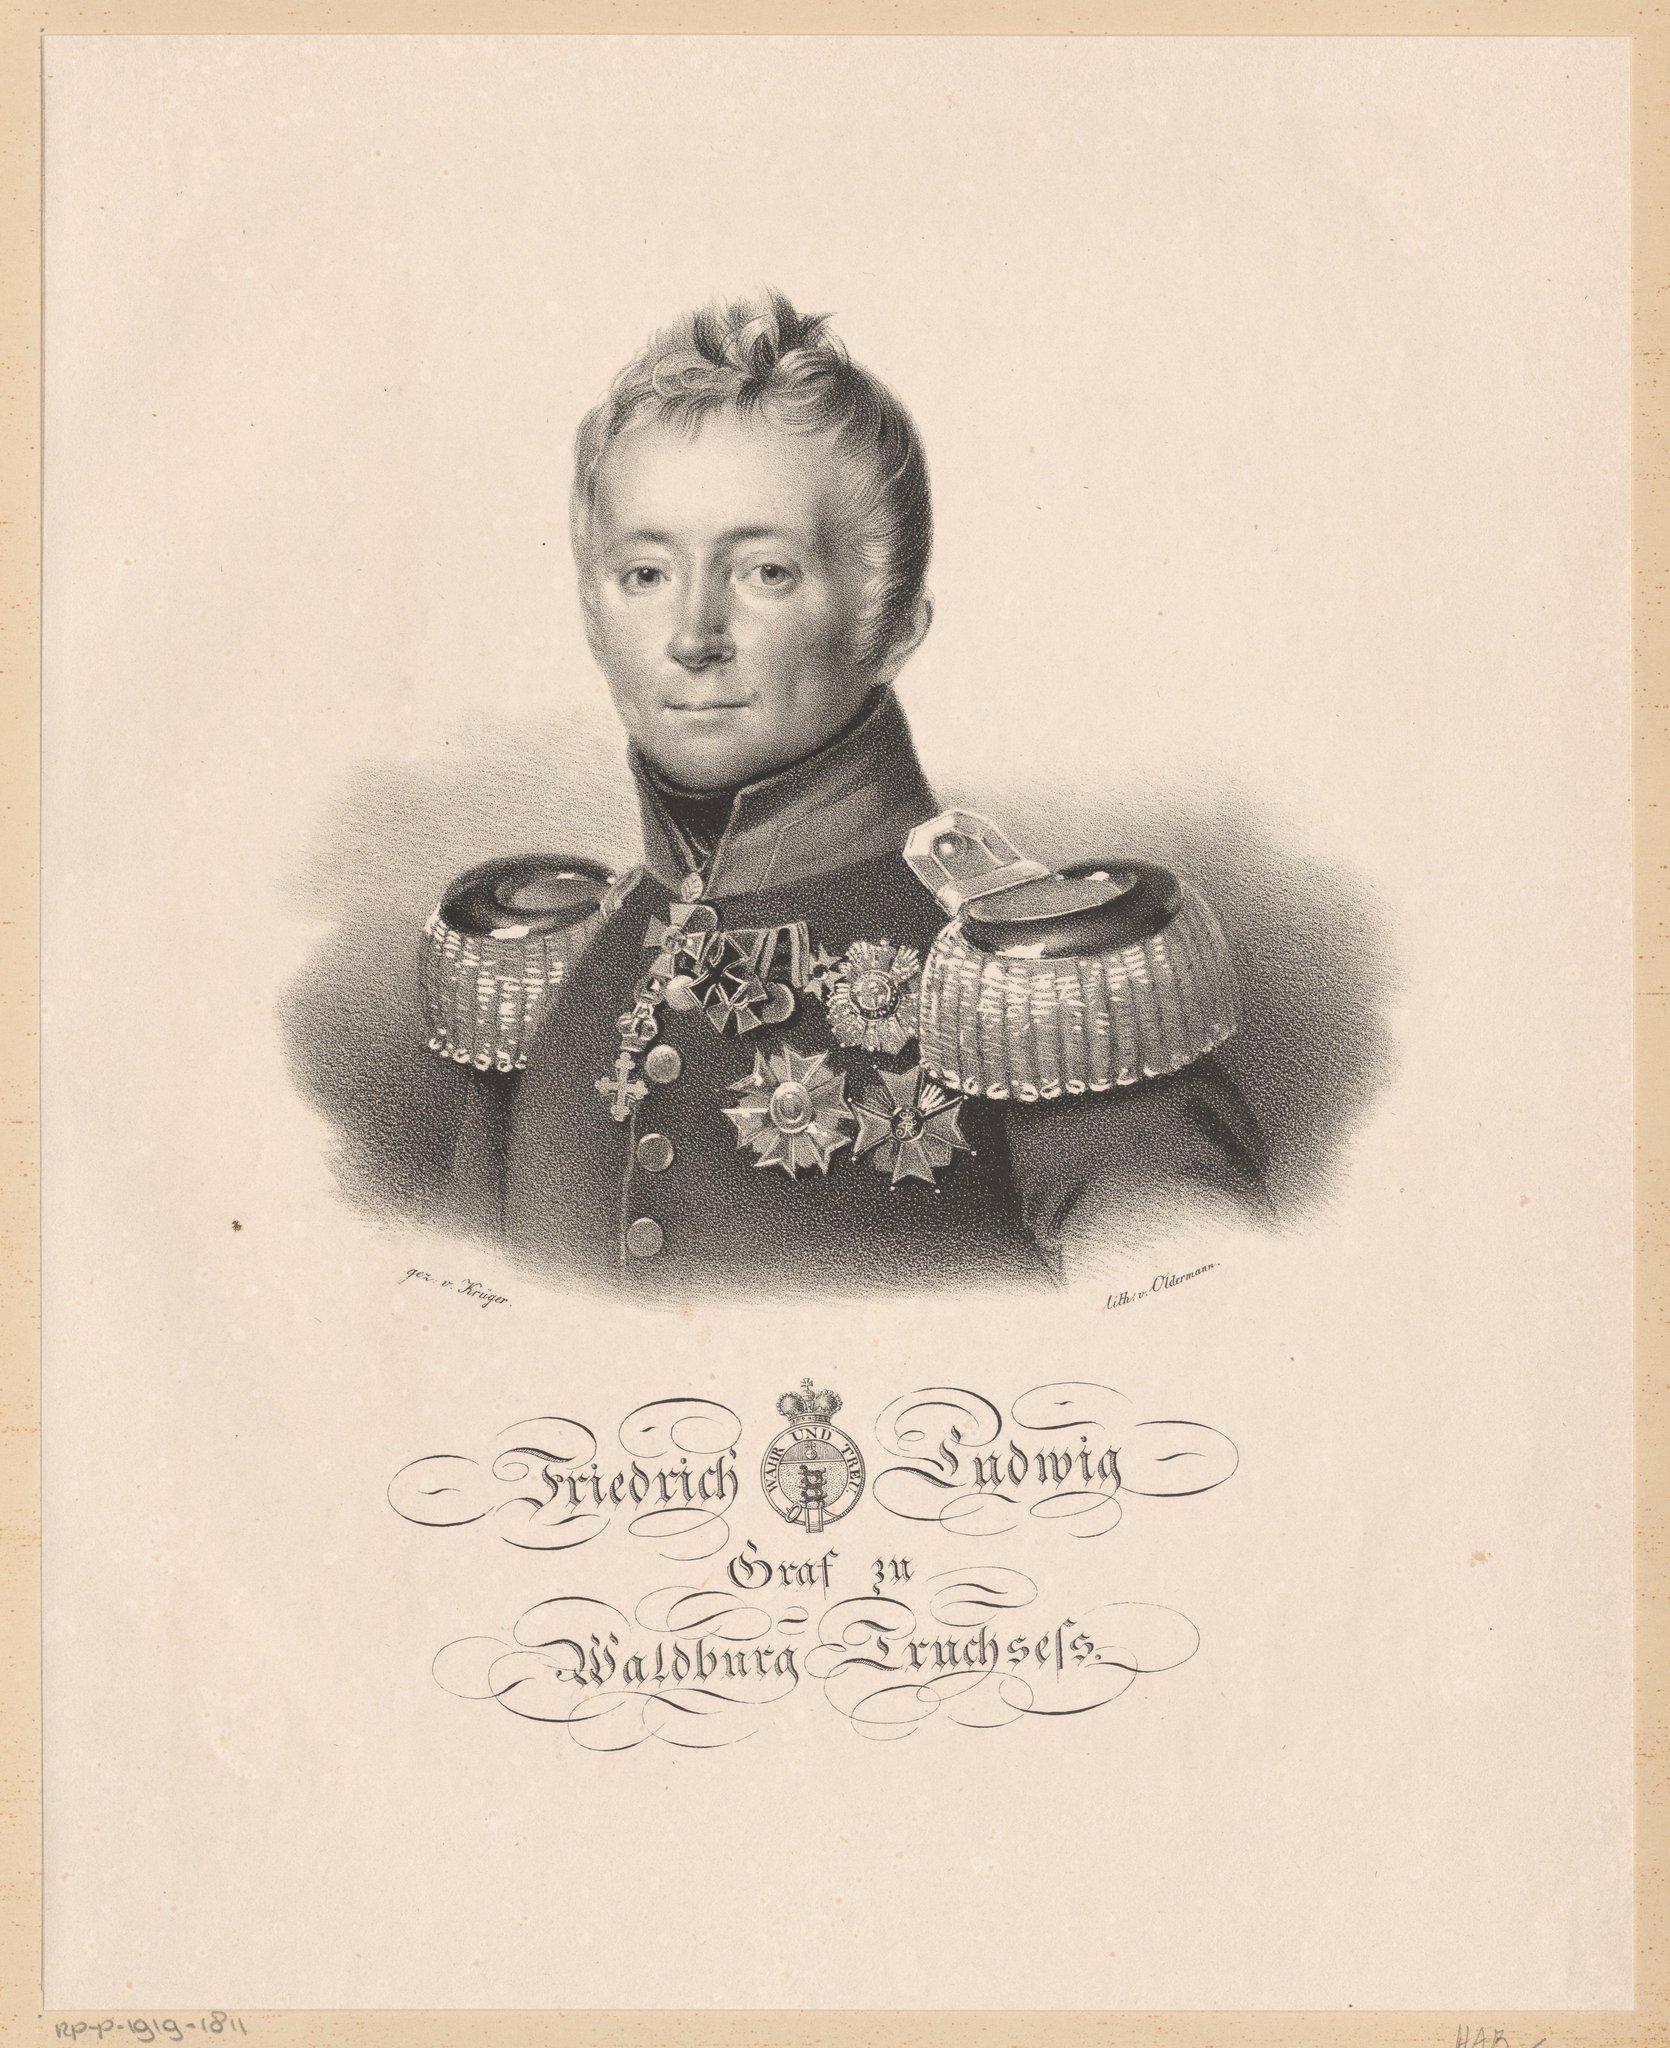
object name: print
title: Portret van Friedrich Ludwig III Truchsess zu Waldburg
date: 1812-1874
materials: paper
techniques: lithograph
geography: germany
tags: politician, commander-in-chief, general, marshal, historical persons, politician, e.g. party leader, medals and other marks of military honour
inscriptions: collector's mark: Lugt 2228